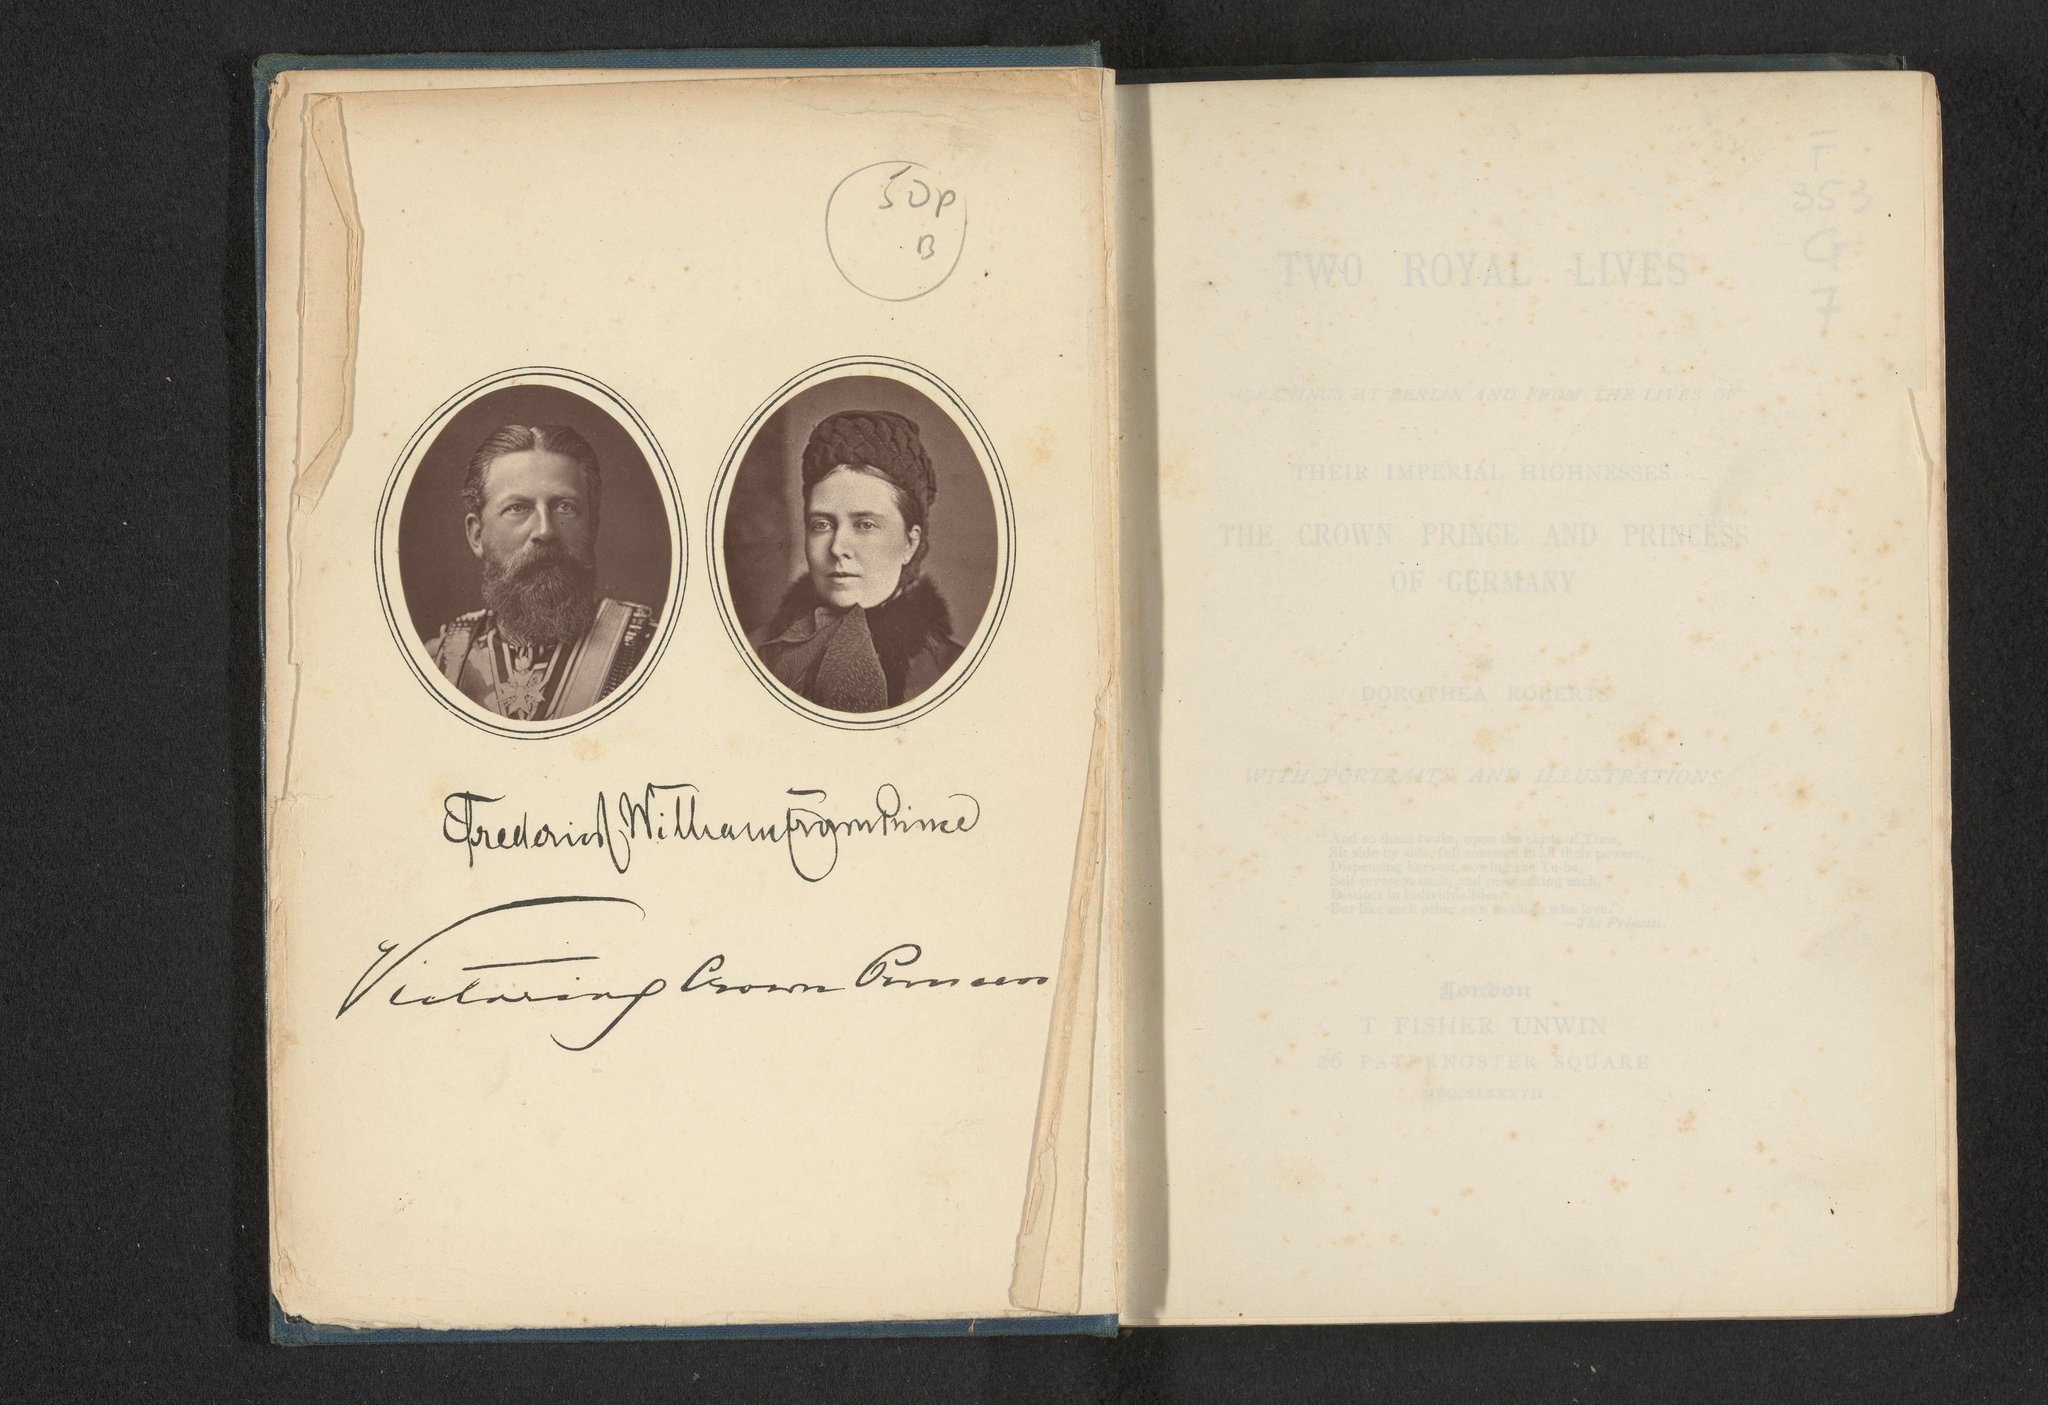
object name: photomechanical print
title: Dubbelportret van keizer Frederik III van Pruisen en keizerin Victoria van Pruisen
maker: Anonymous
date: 1883-1888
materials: paper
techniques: woodburytype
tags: victoria van saksen-coburg en gotha (duits keizerin), ruler, sovereign - bb - female ruler, ruler, sovereign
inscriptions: inscription: ‘Frederick William Crown Prince Victoria Crown Princess’